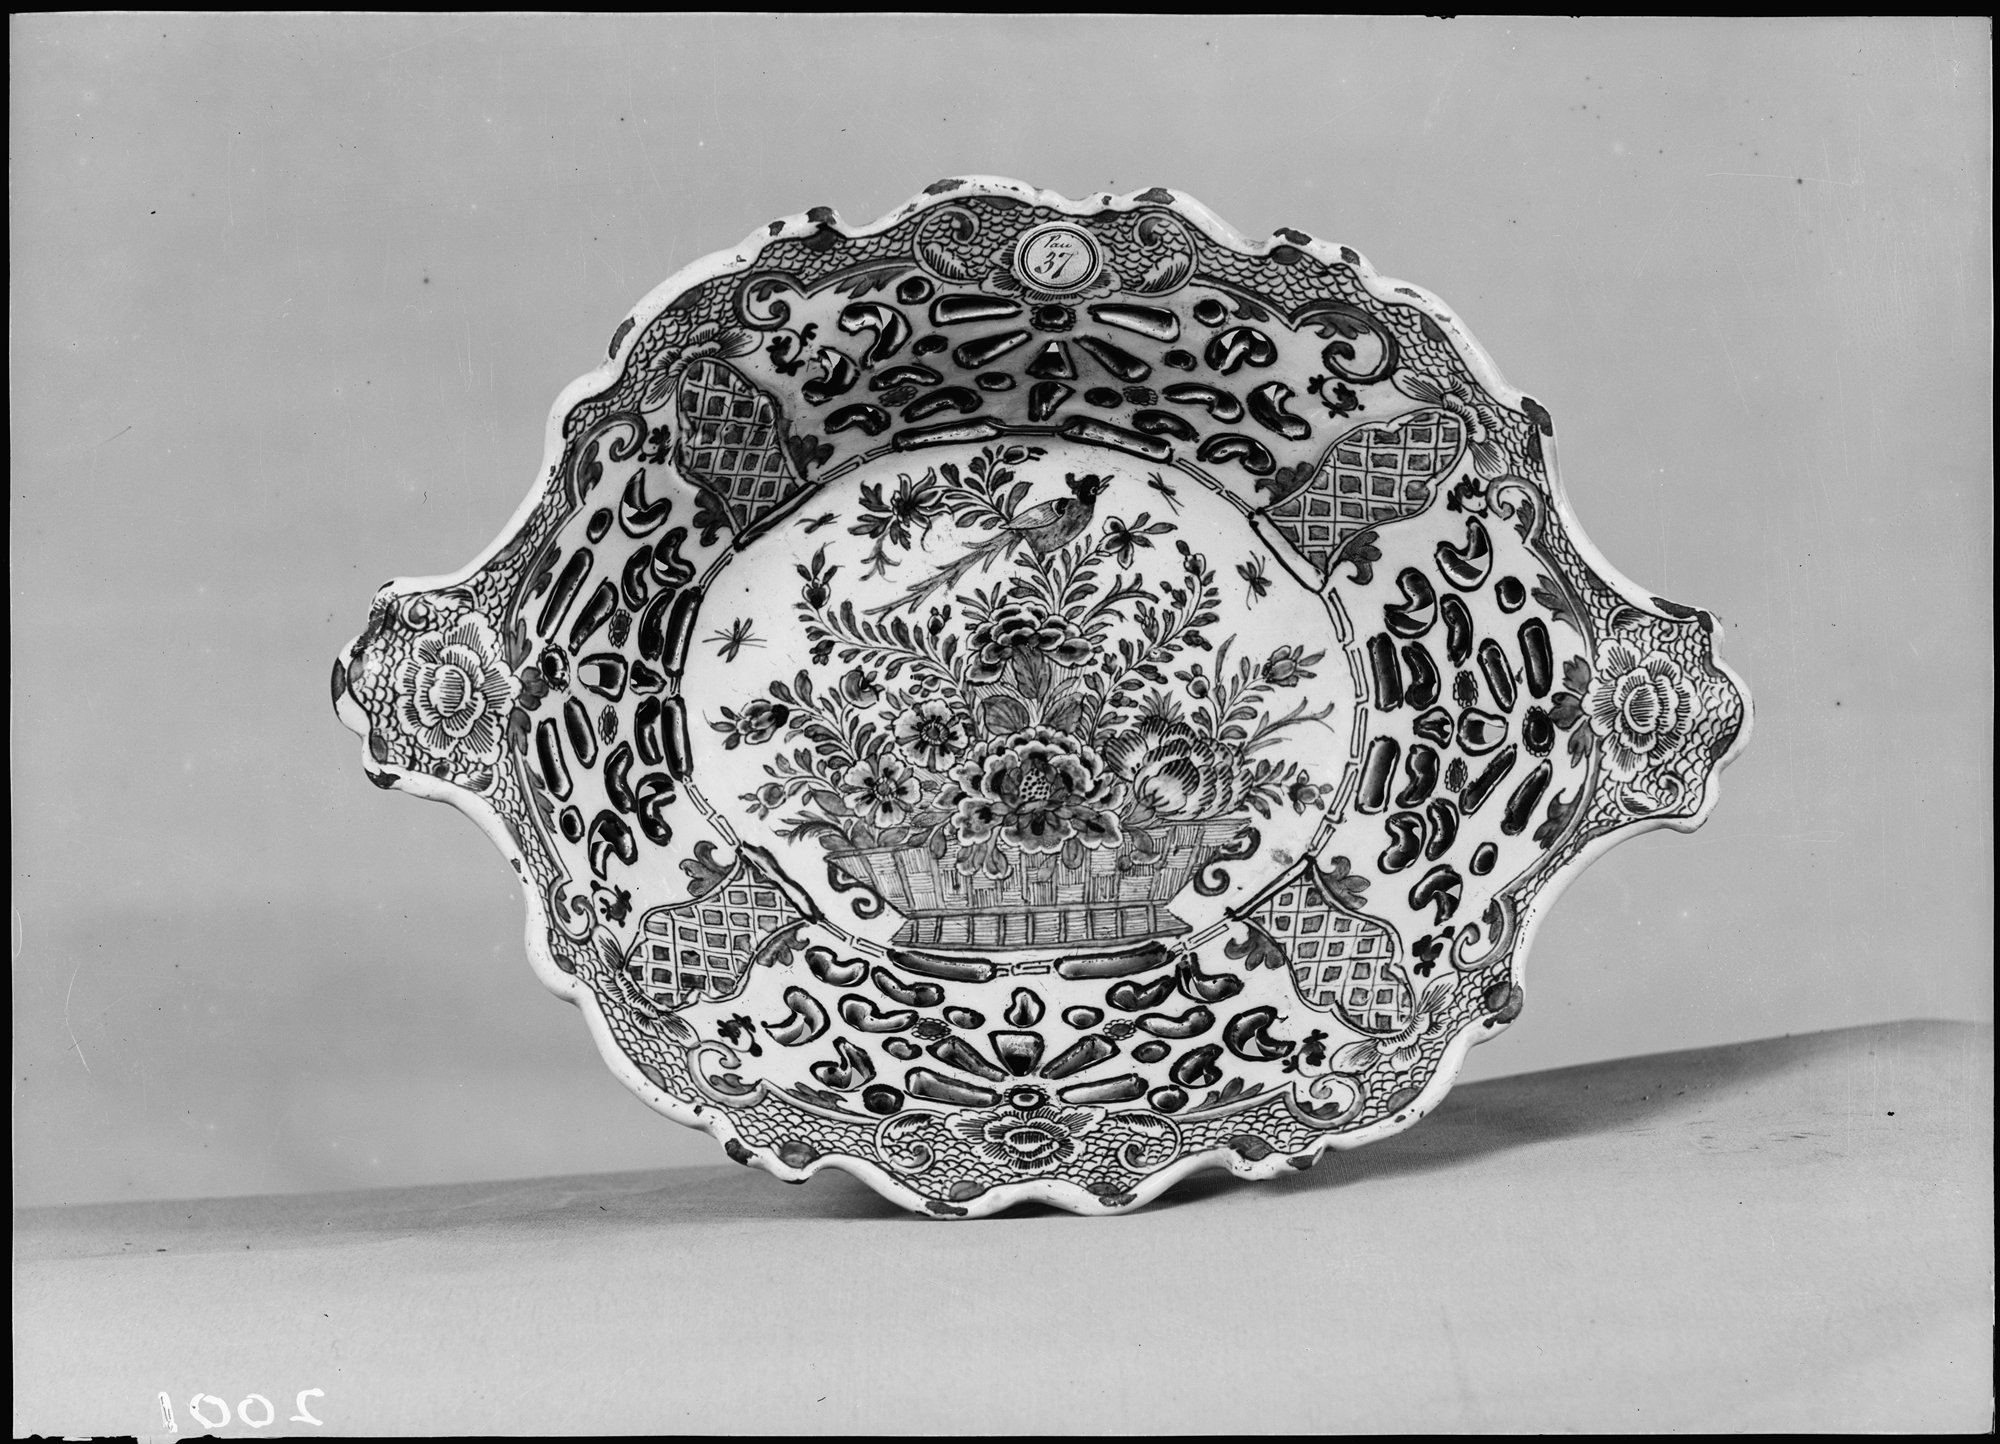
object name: fruit dish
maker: the dreye porceleyne flesschen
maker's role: maker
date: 1701-1800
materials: earthenware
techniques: glazing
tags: birds,insects,flowers